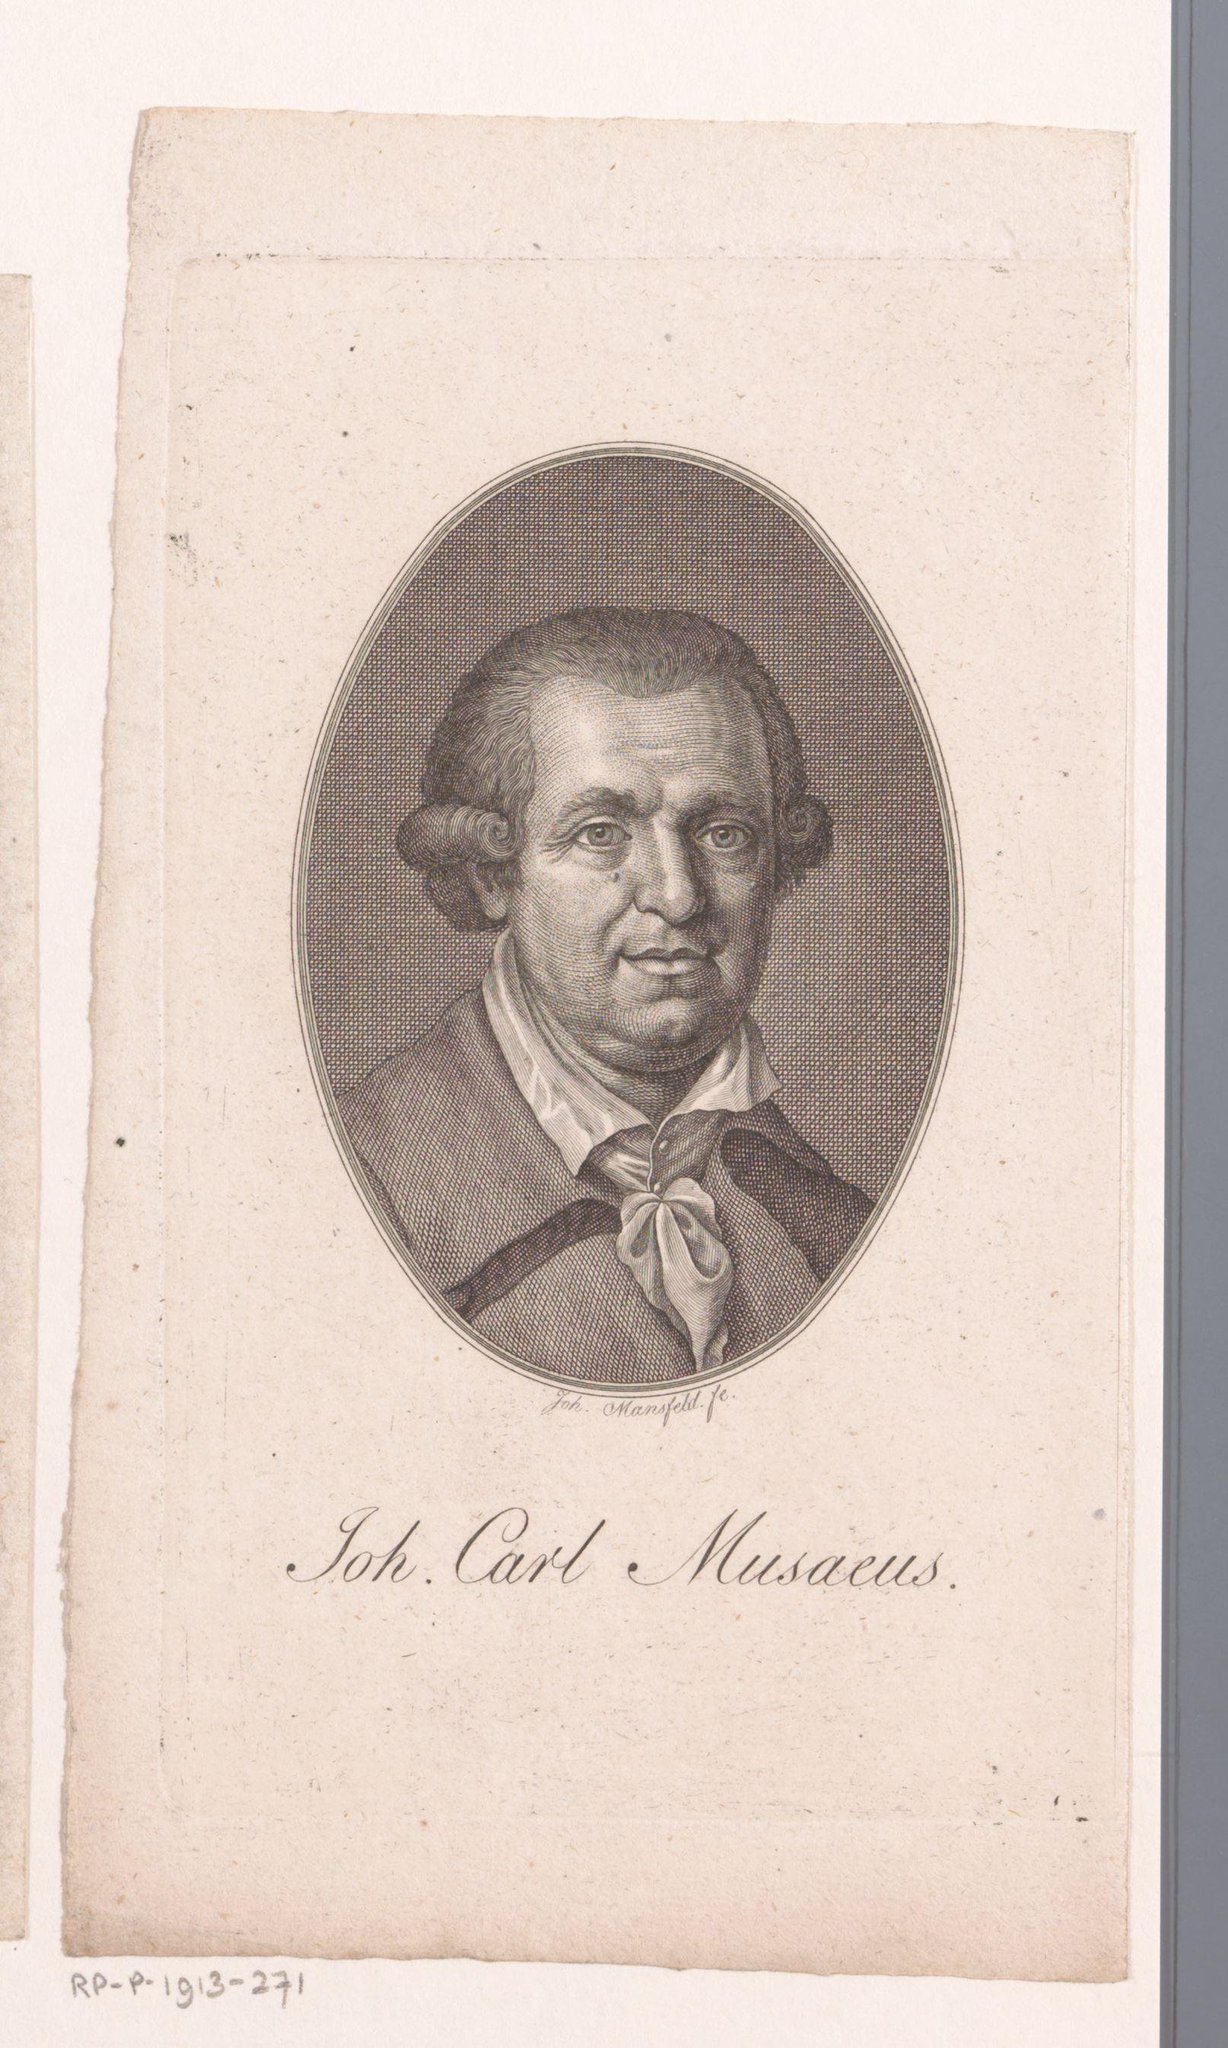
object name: print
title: Portret van Johann Carl August Musäus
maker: johann ernst mansfeld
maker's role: print maker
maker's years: 1739-1796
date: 1749-1796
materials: paper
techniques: engraving, etching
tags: historical persons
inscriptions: collector's mark: Lugt 2228